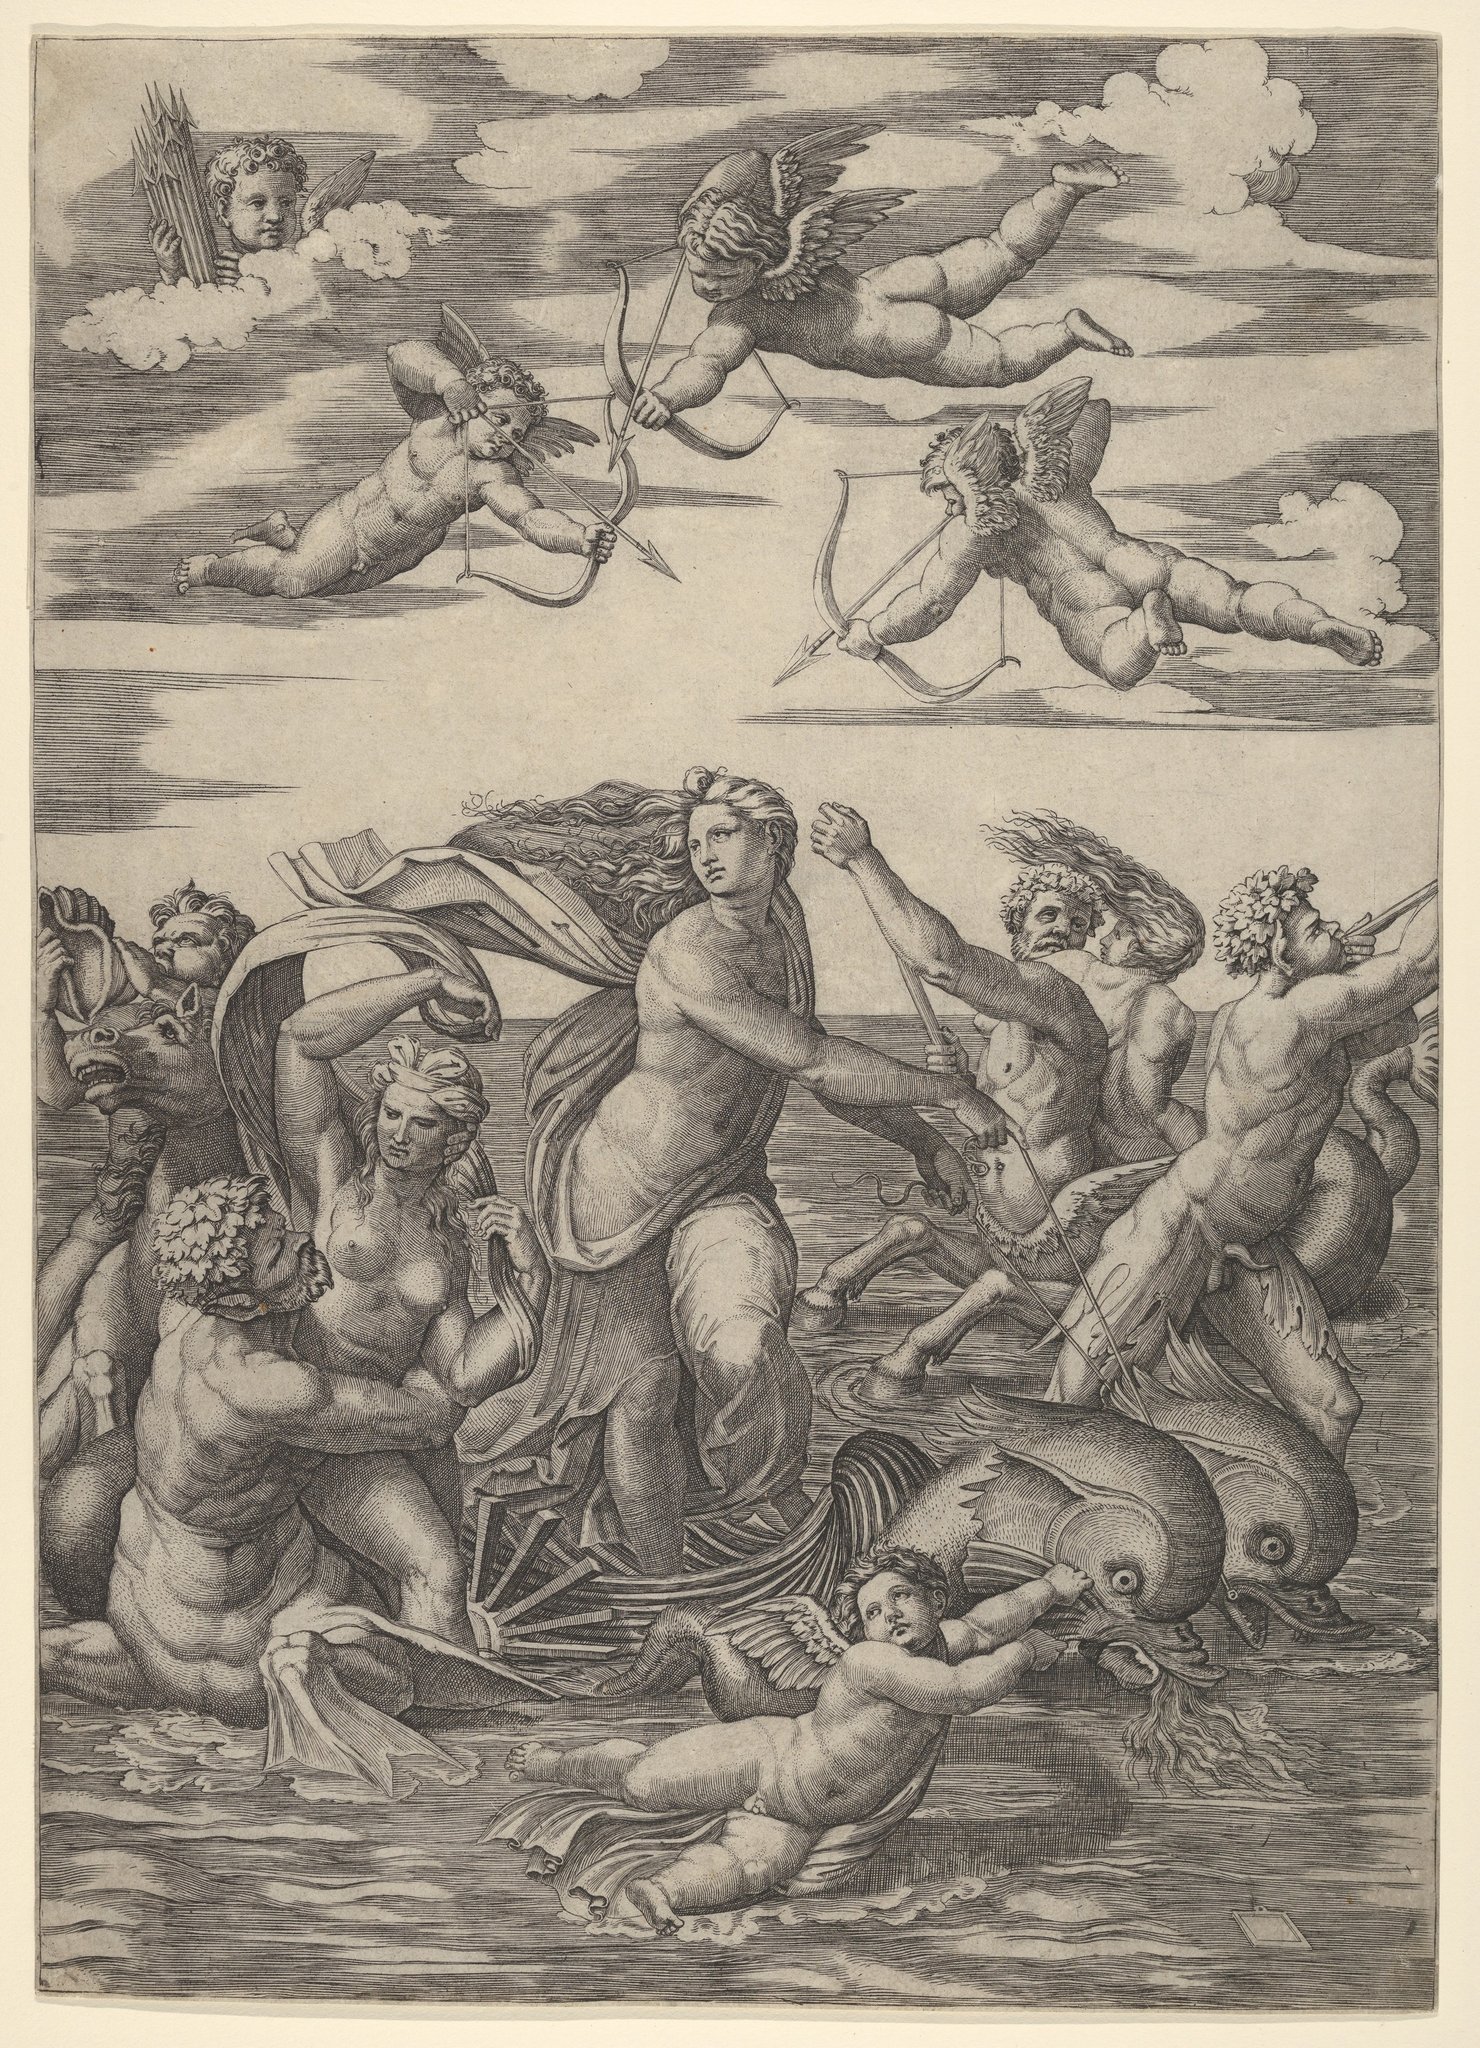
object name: print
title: Galatea standing in a water-chariot pulled by two dolphins, surrounded by tritons, nereids, and putti, three of which prepare to shoot arrows from above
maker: marcantonio raimondi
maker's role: artist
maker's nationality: italian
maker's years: 1475-1534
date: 1515-1516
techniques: engraving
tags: bow and arrow,triton,galatea,nymphs,dolphins,chariots